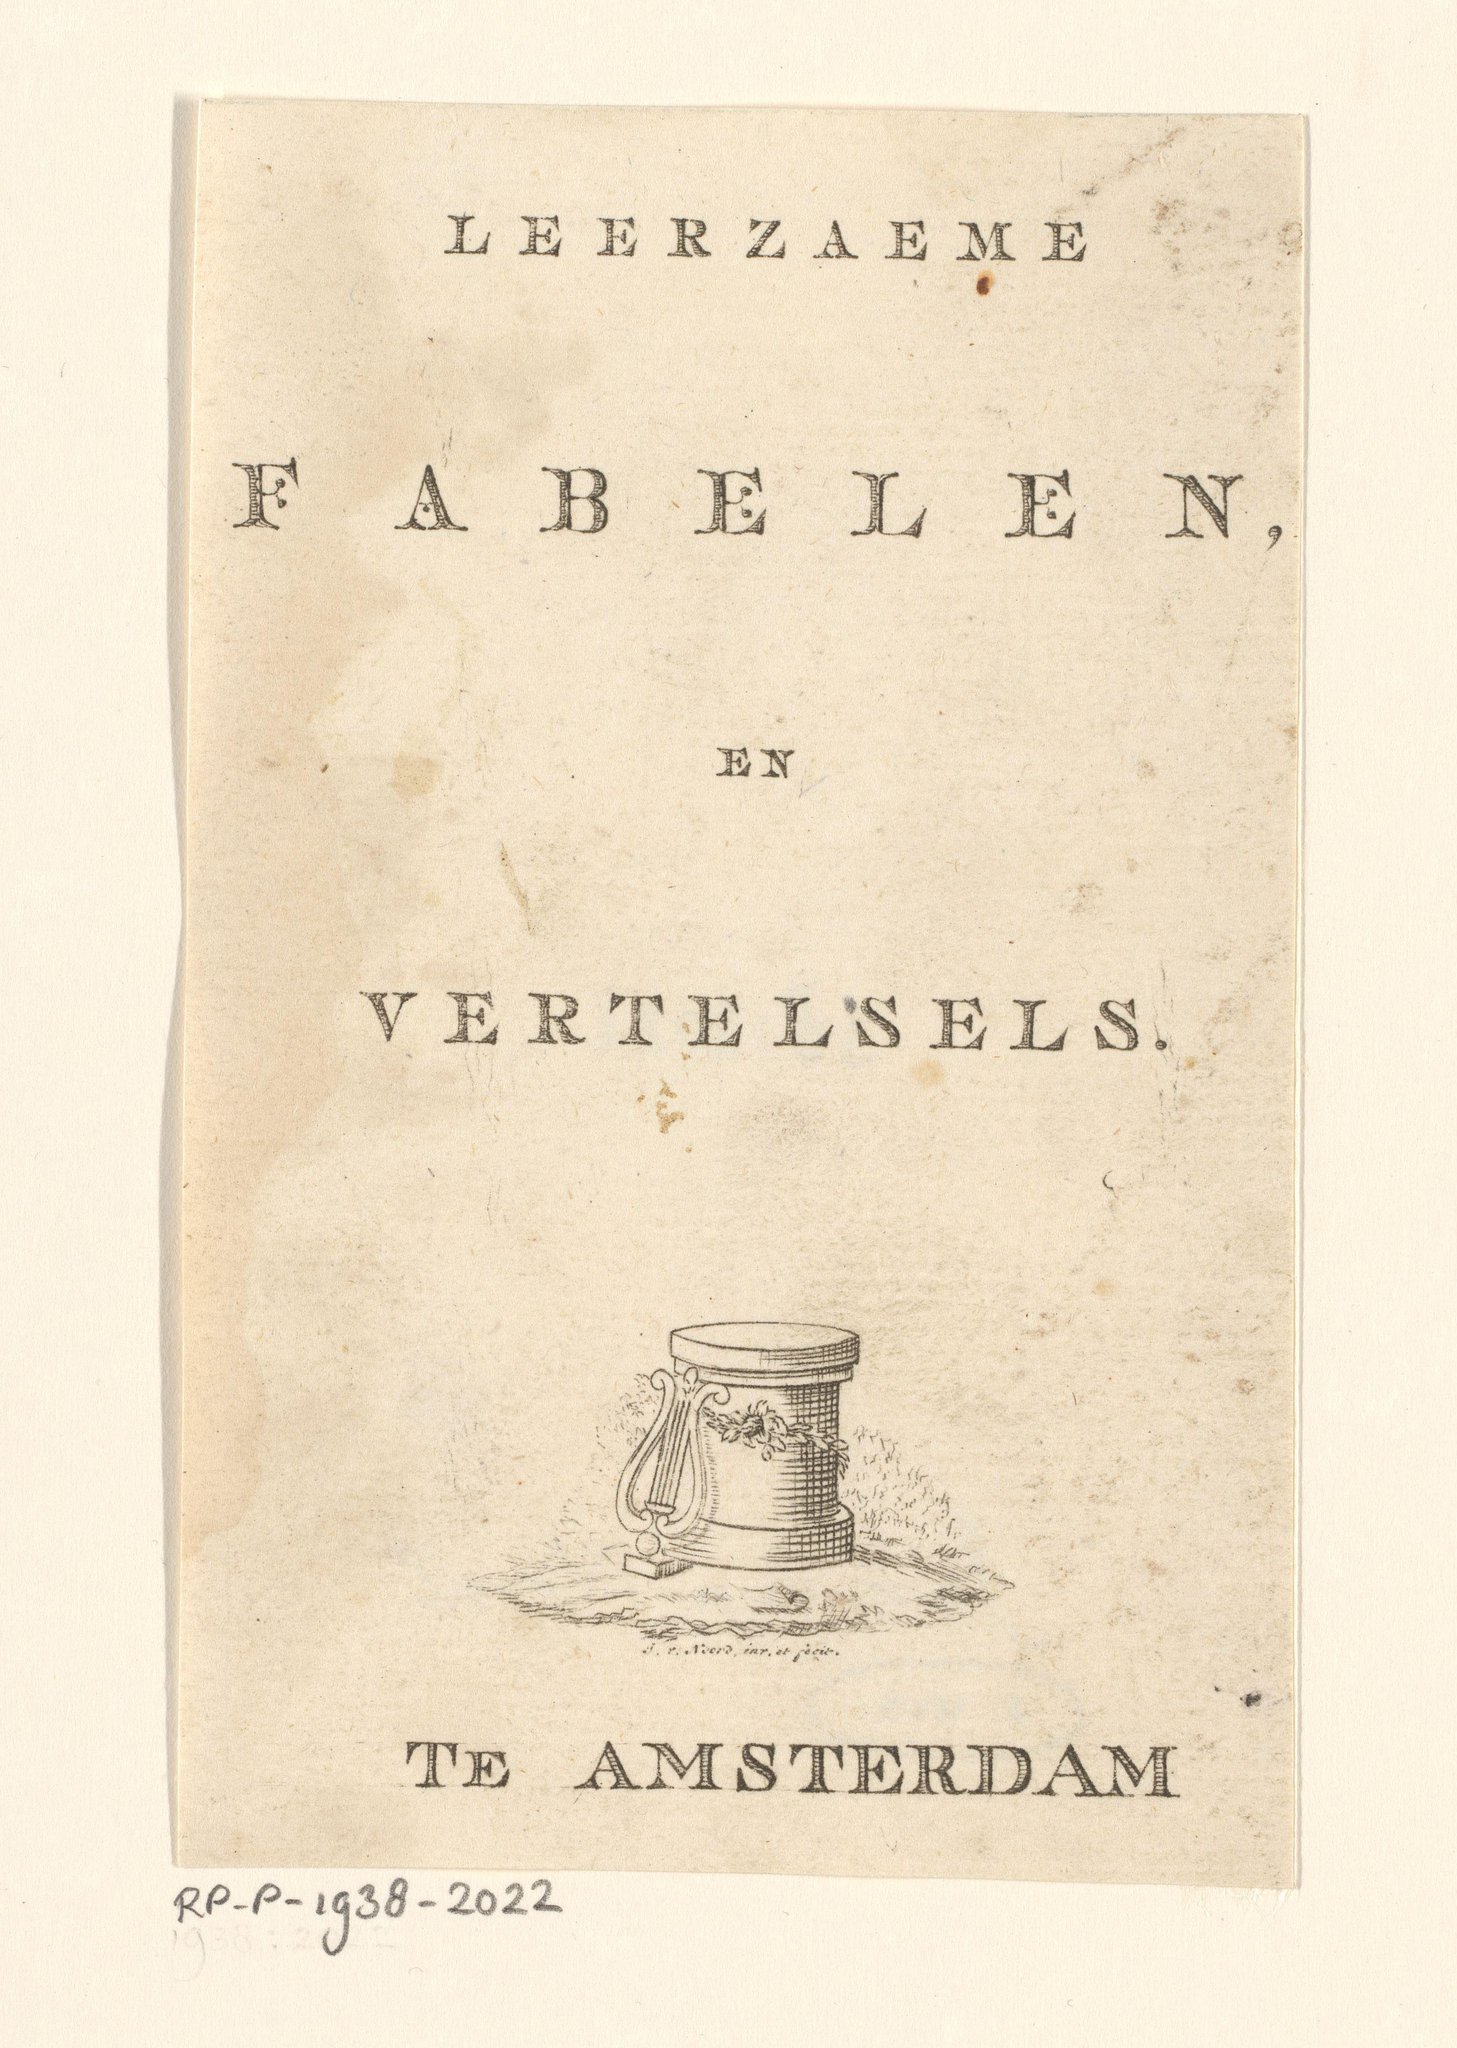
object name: titelblad, titelpagina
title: Titelpagina voor: H. T. Terkamp, Leerzaeme fabelen, en vertelsels, 1787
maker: jan van noort (1756-1837)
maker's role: painter, print maker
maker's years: 1756-1837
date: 1766-1837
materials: paper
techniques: engraving, etching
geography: leiden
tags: column, pillar ~ architecture, lyre, cithara, psaltery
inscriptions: collector's mark: Lugt 2228, collector's mark: Lugt 2760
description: Titelpagina voor: Terkamp, Hermanus Theodorus. Leerzaeme fabelen, en vertelsels. Leiden: Wiggert Hendrik Gryp, 1787.